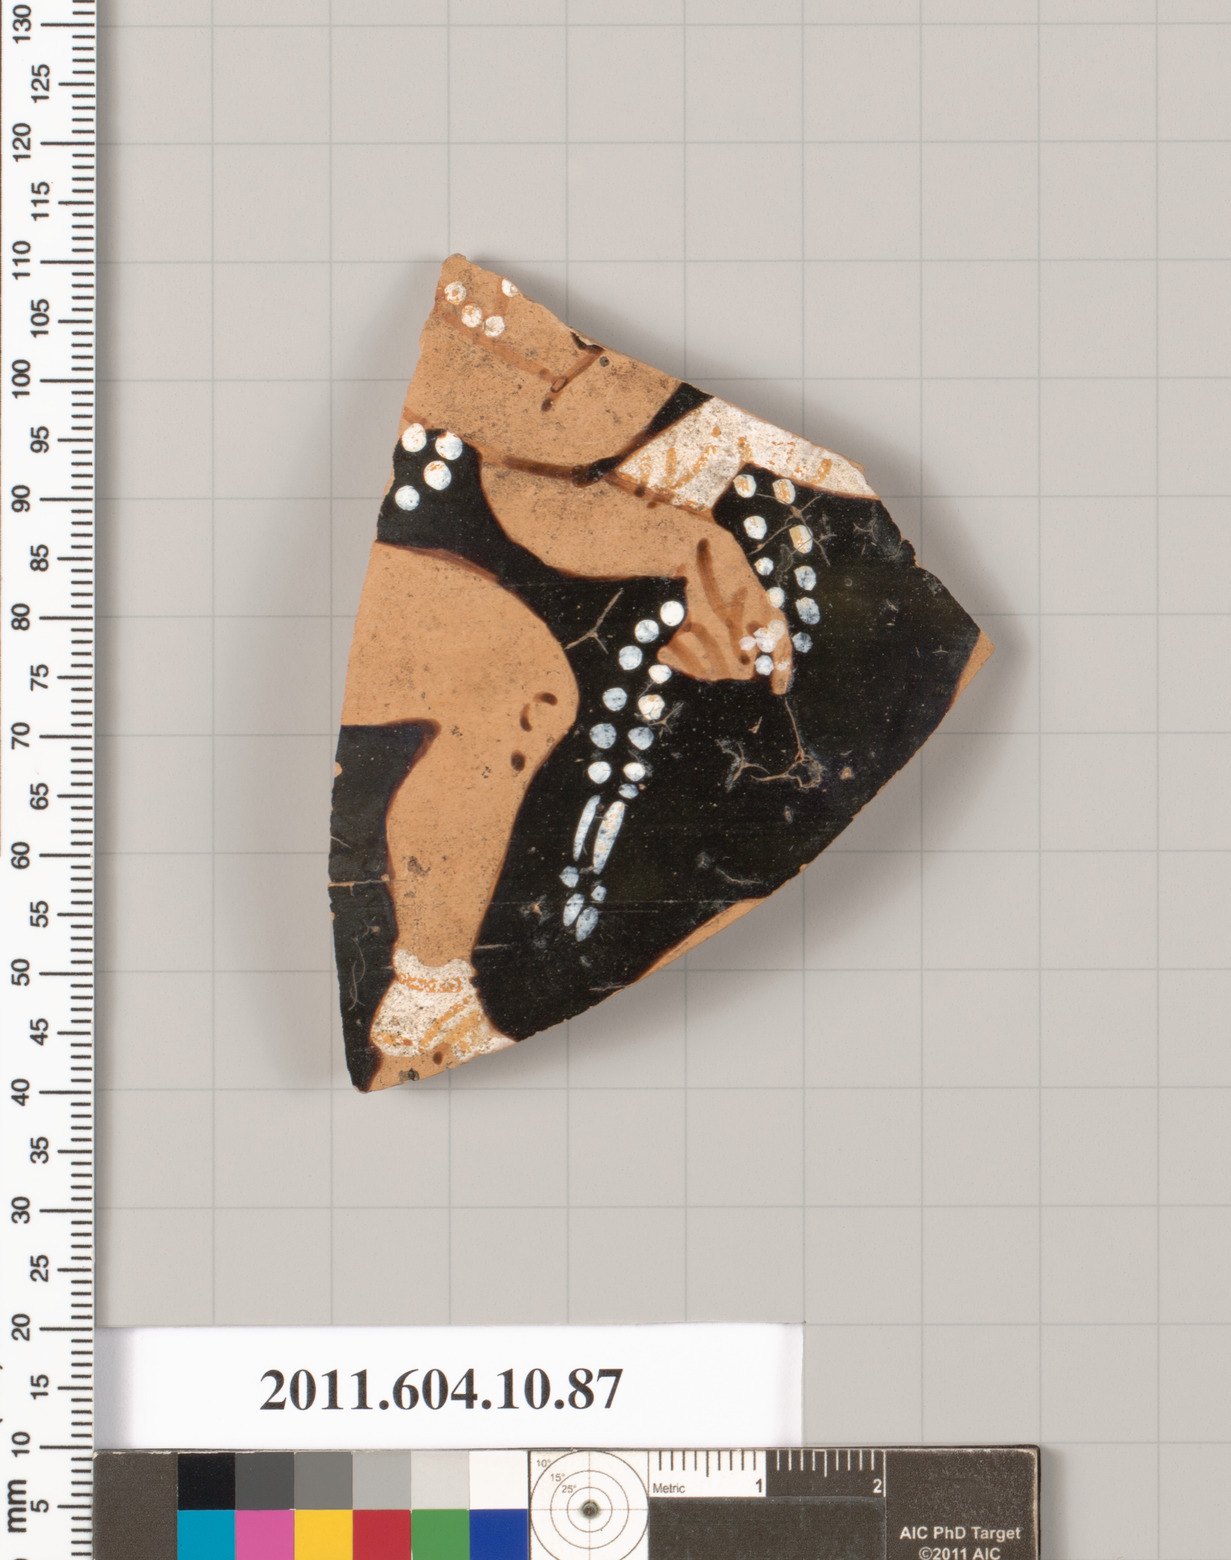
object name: undetermined closed shape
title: Terracotta fragment of a closed shape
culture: etruscan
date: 367-335 BCE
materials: terracotta